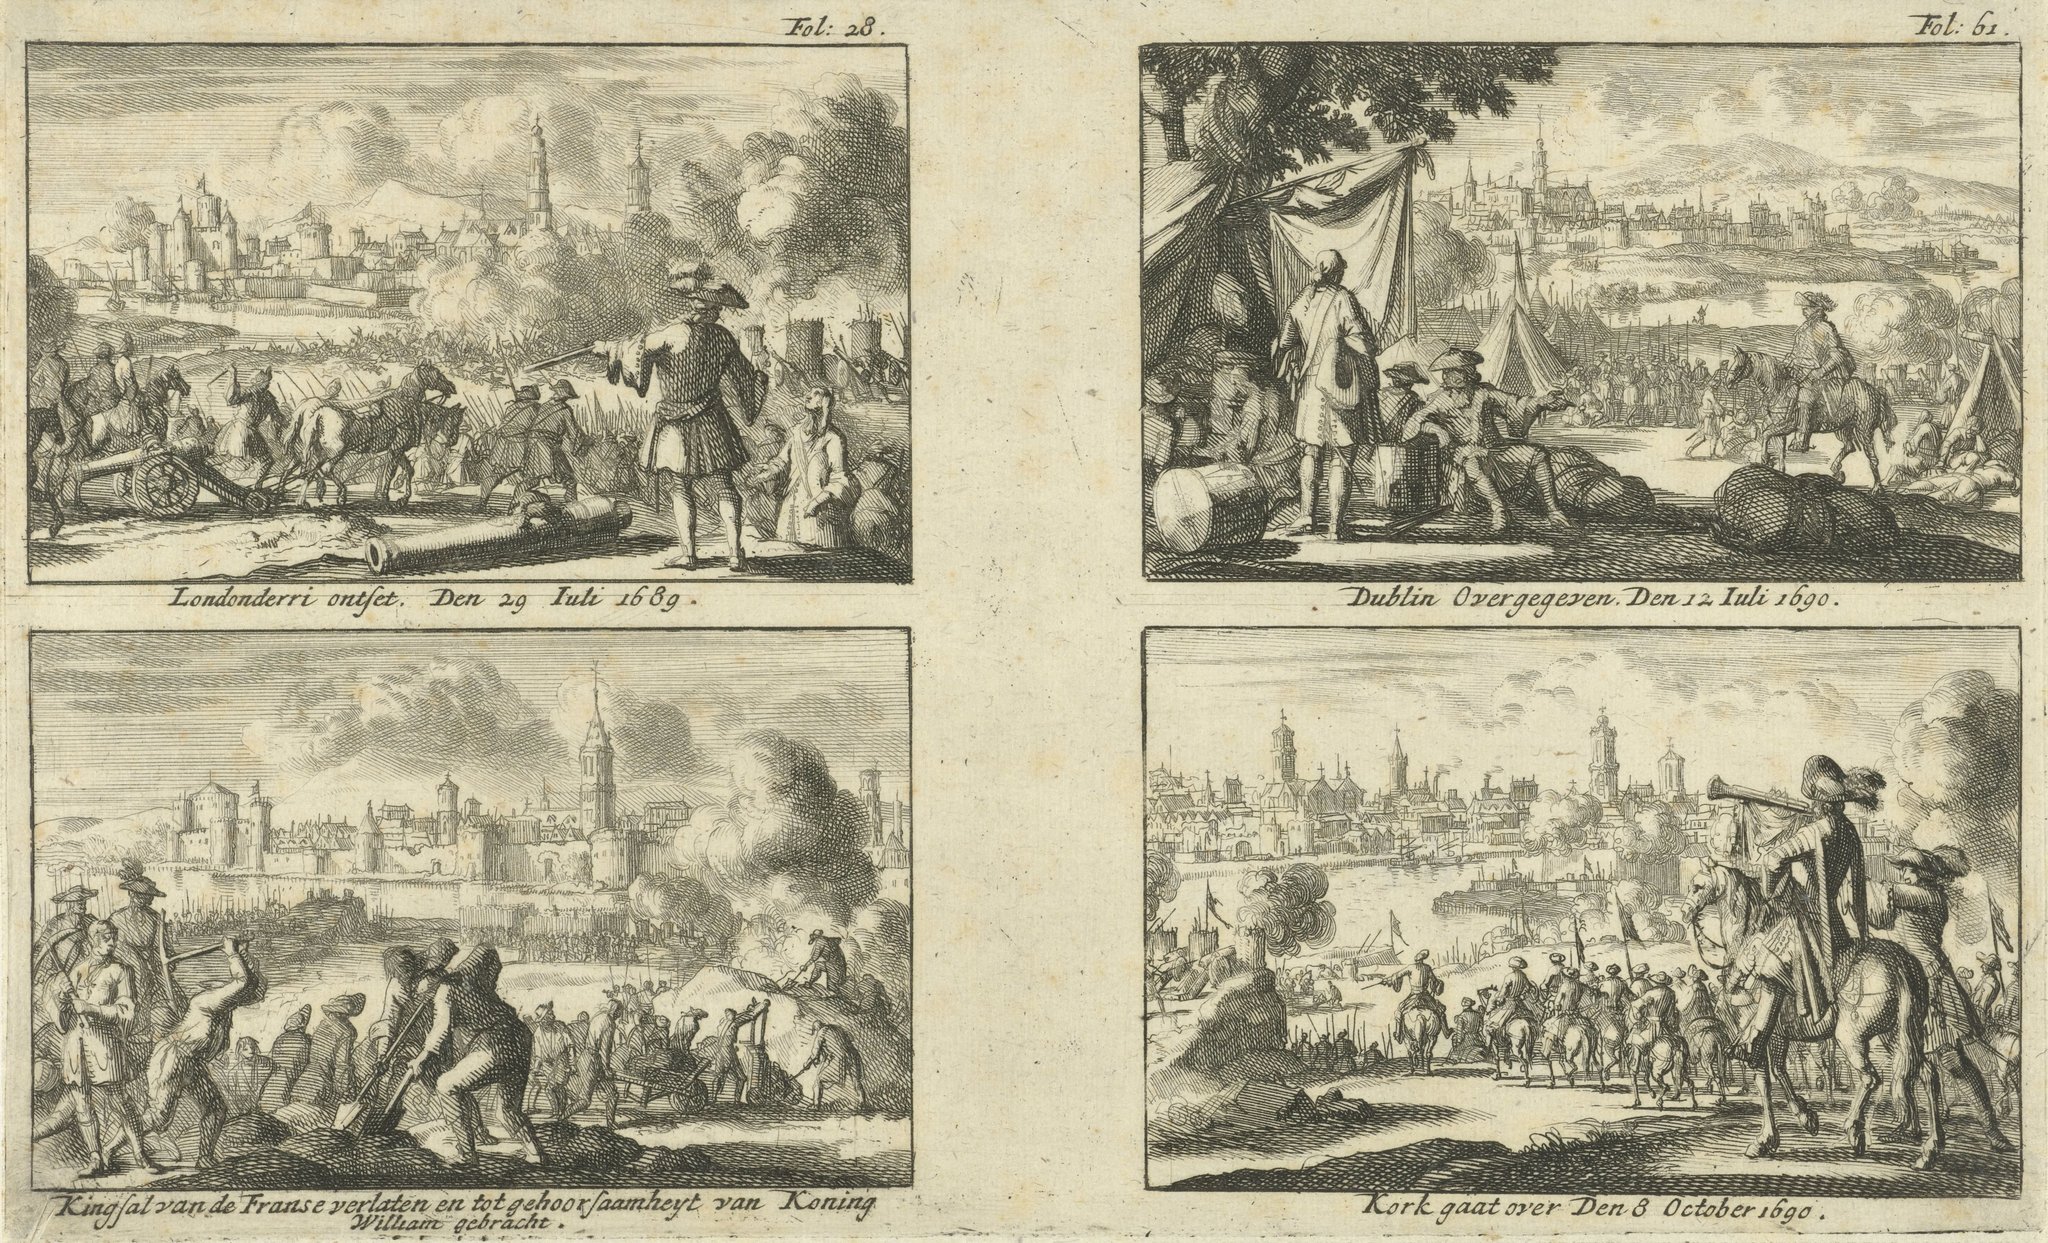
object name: book illustration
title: Strijd in Ierland bij Londonderry en Kinsale, 1689 en de strijd in Ierland bij Dublin en Cork, 1690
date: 1690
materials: paper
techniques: etching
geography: amsterdam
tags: jacobus ii (koning van engeland en schotland), the hague, william iii (prince of orange and king of england, scotland, and ireland), siege, position war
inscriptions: collector's mark: Lugt 2228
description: Blad met vier voorstellingen van één plaat. De voorstellingen geven de strijd tussen de legers van Willem III en Jacobus II in Ierland weer. Linksboven: Het ontzet van Londonderry op 28 juli 1689 na tevergeefs vanaf 18 april door het leger van koning Jacobus II belegerd te zijn geweest. Linksonder: Kinsale wordt verlaten door de Franse troepen, 1689-1690. Prent bovenaan gemerkt: Fol: 28. Rechtsboven: De verovering van Dublin door het leger van Willem III, 12 juli 1690. Rechtsonder: Cork gaat na beleg over naar de zijde van Willem III, 8 oktober 1690. Prent bovenaan gemerkt: Fol: 61.